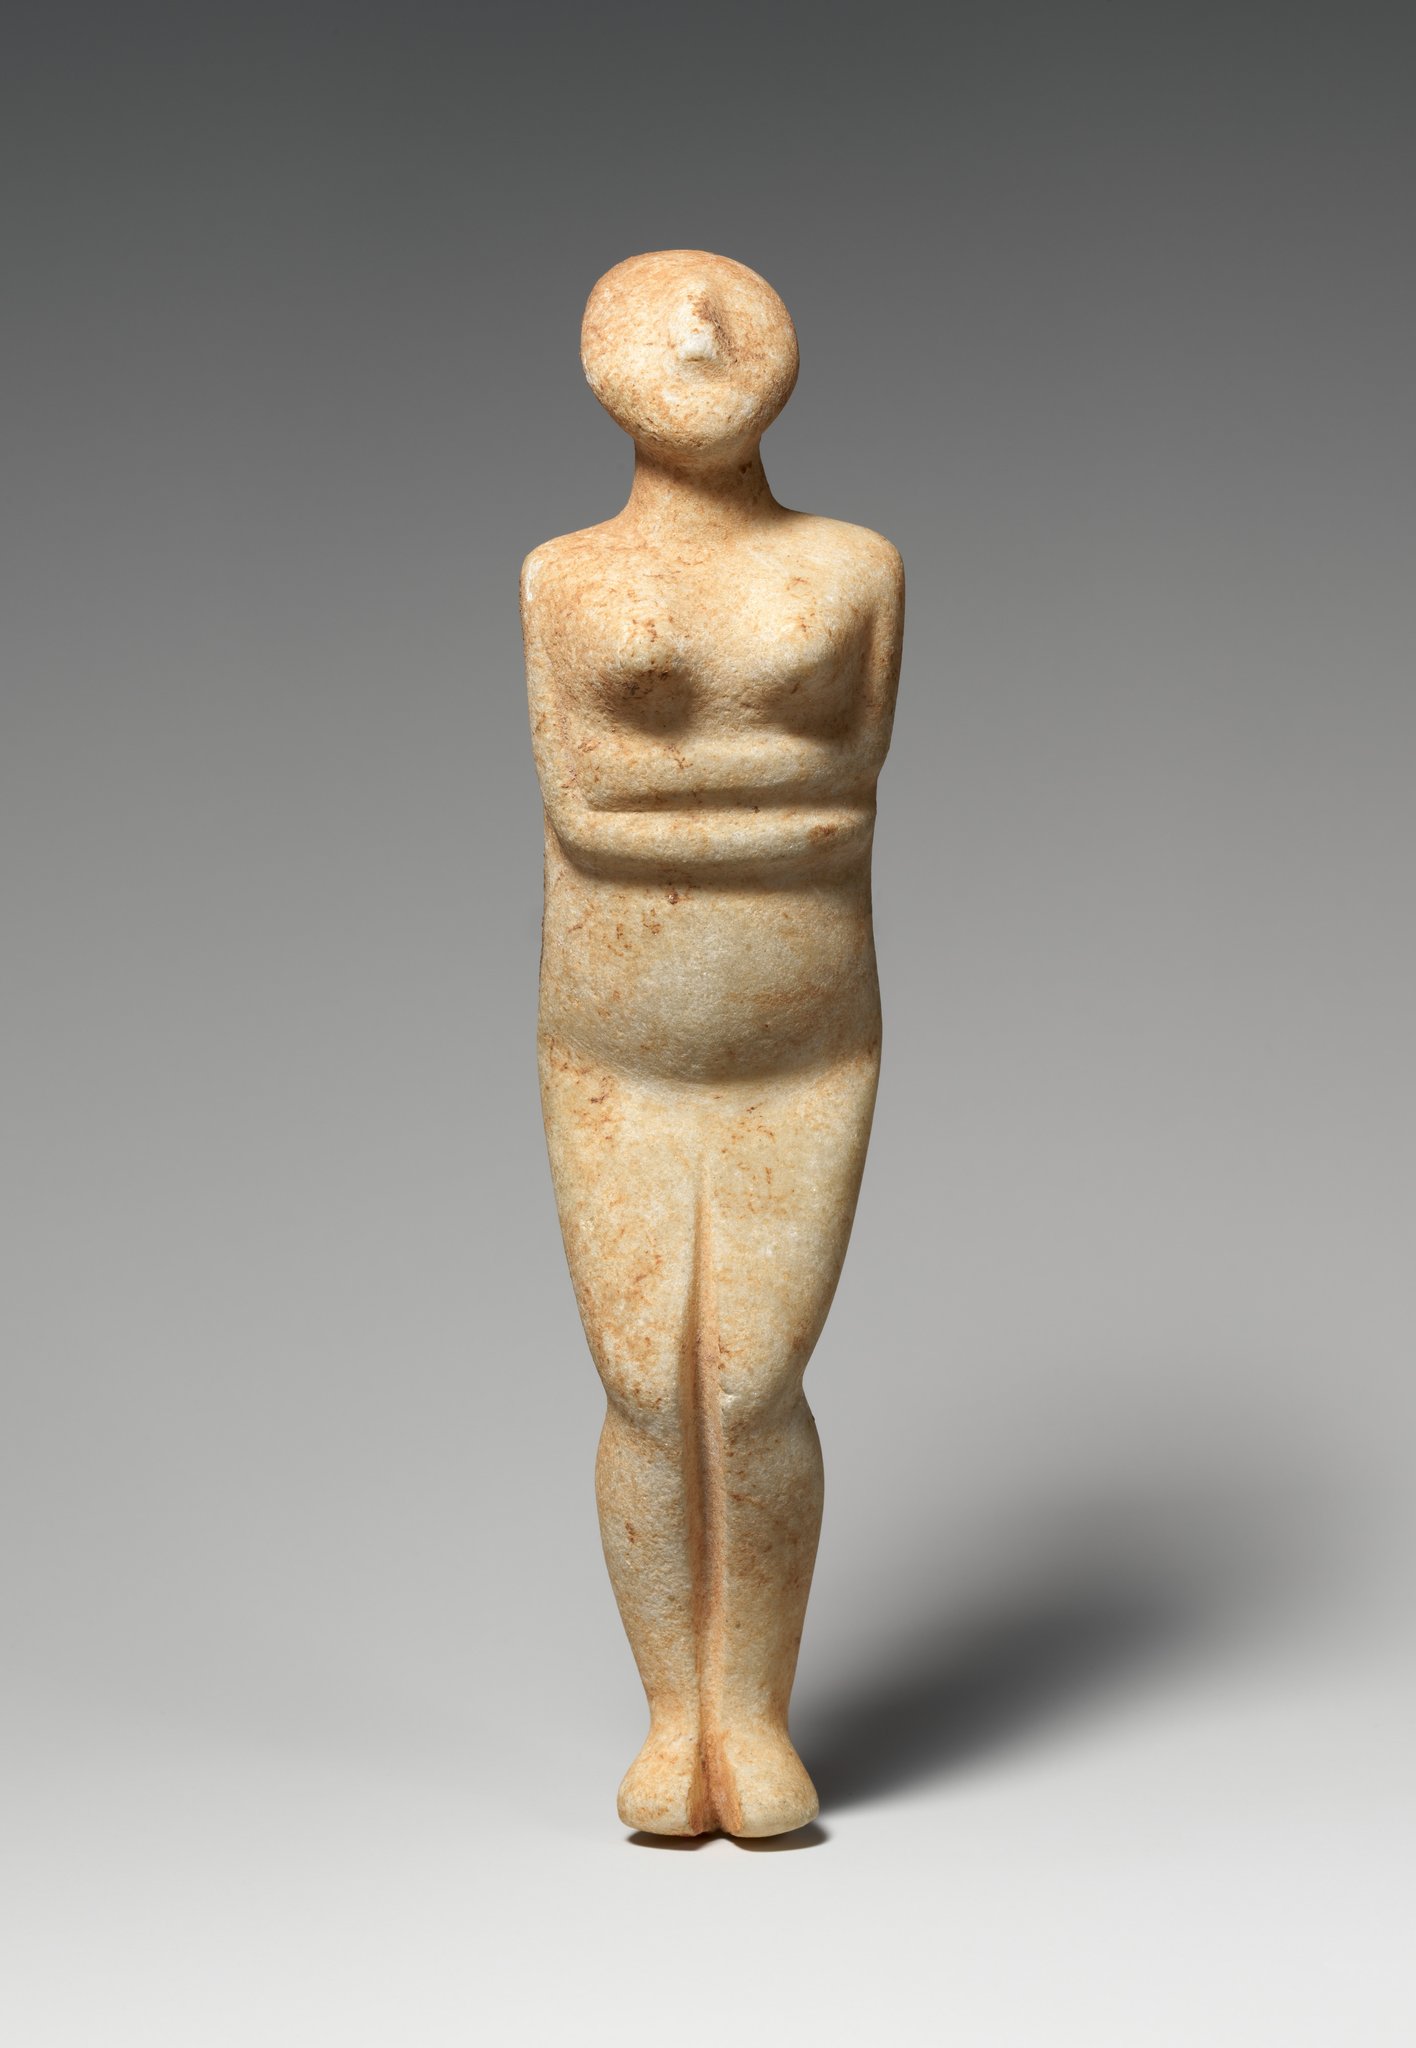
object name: statuette of a woman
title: Marble female figure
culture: cycladic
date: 2700-2600 BCE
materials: marble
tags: female nudes